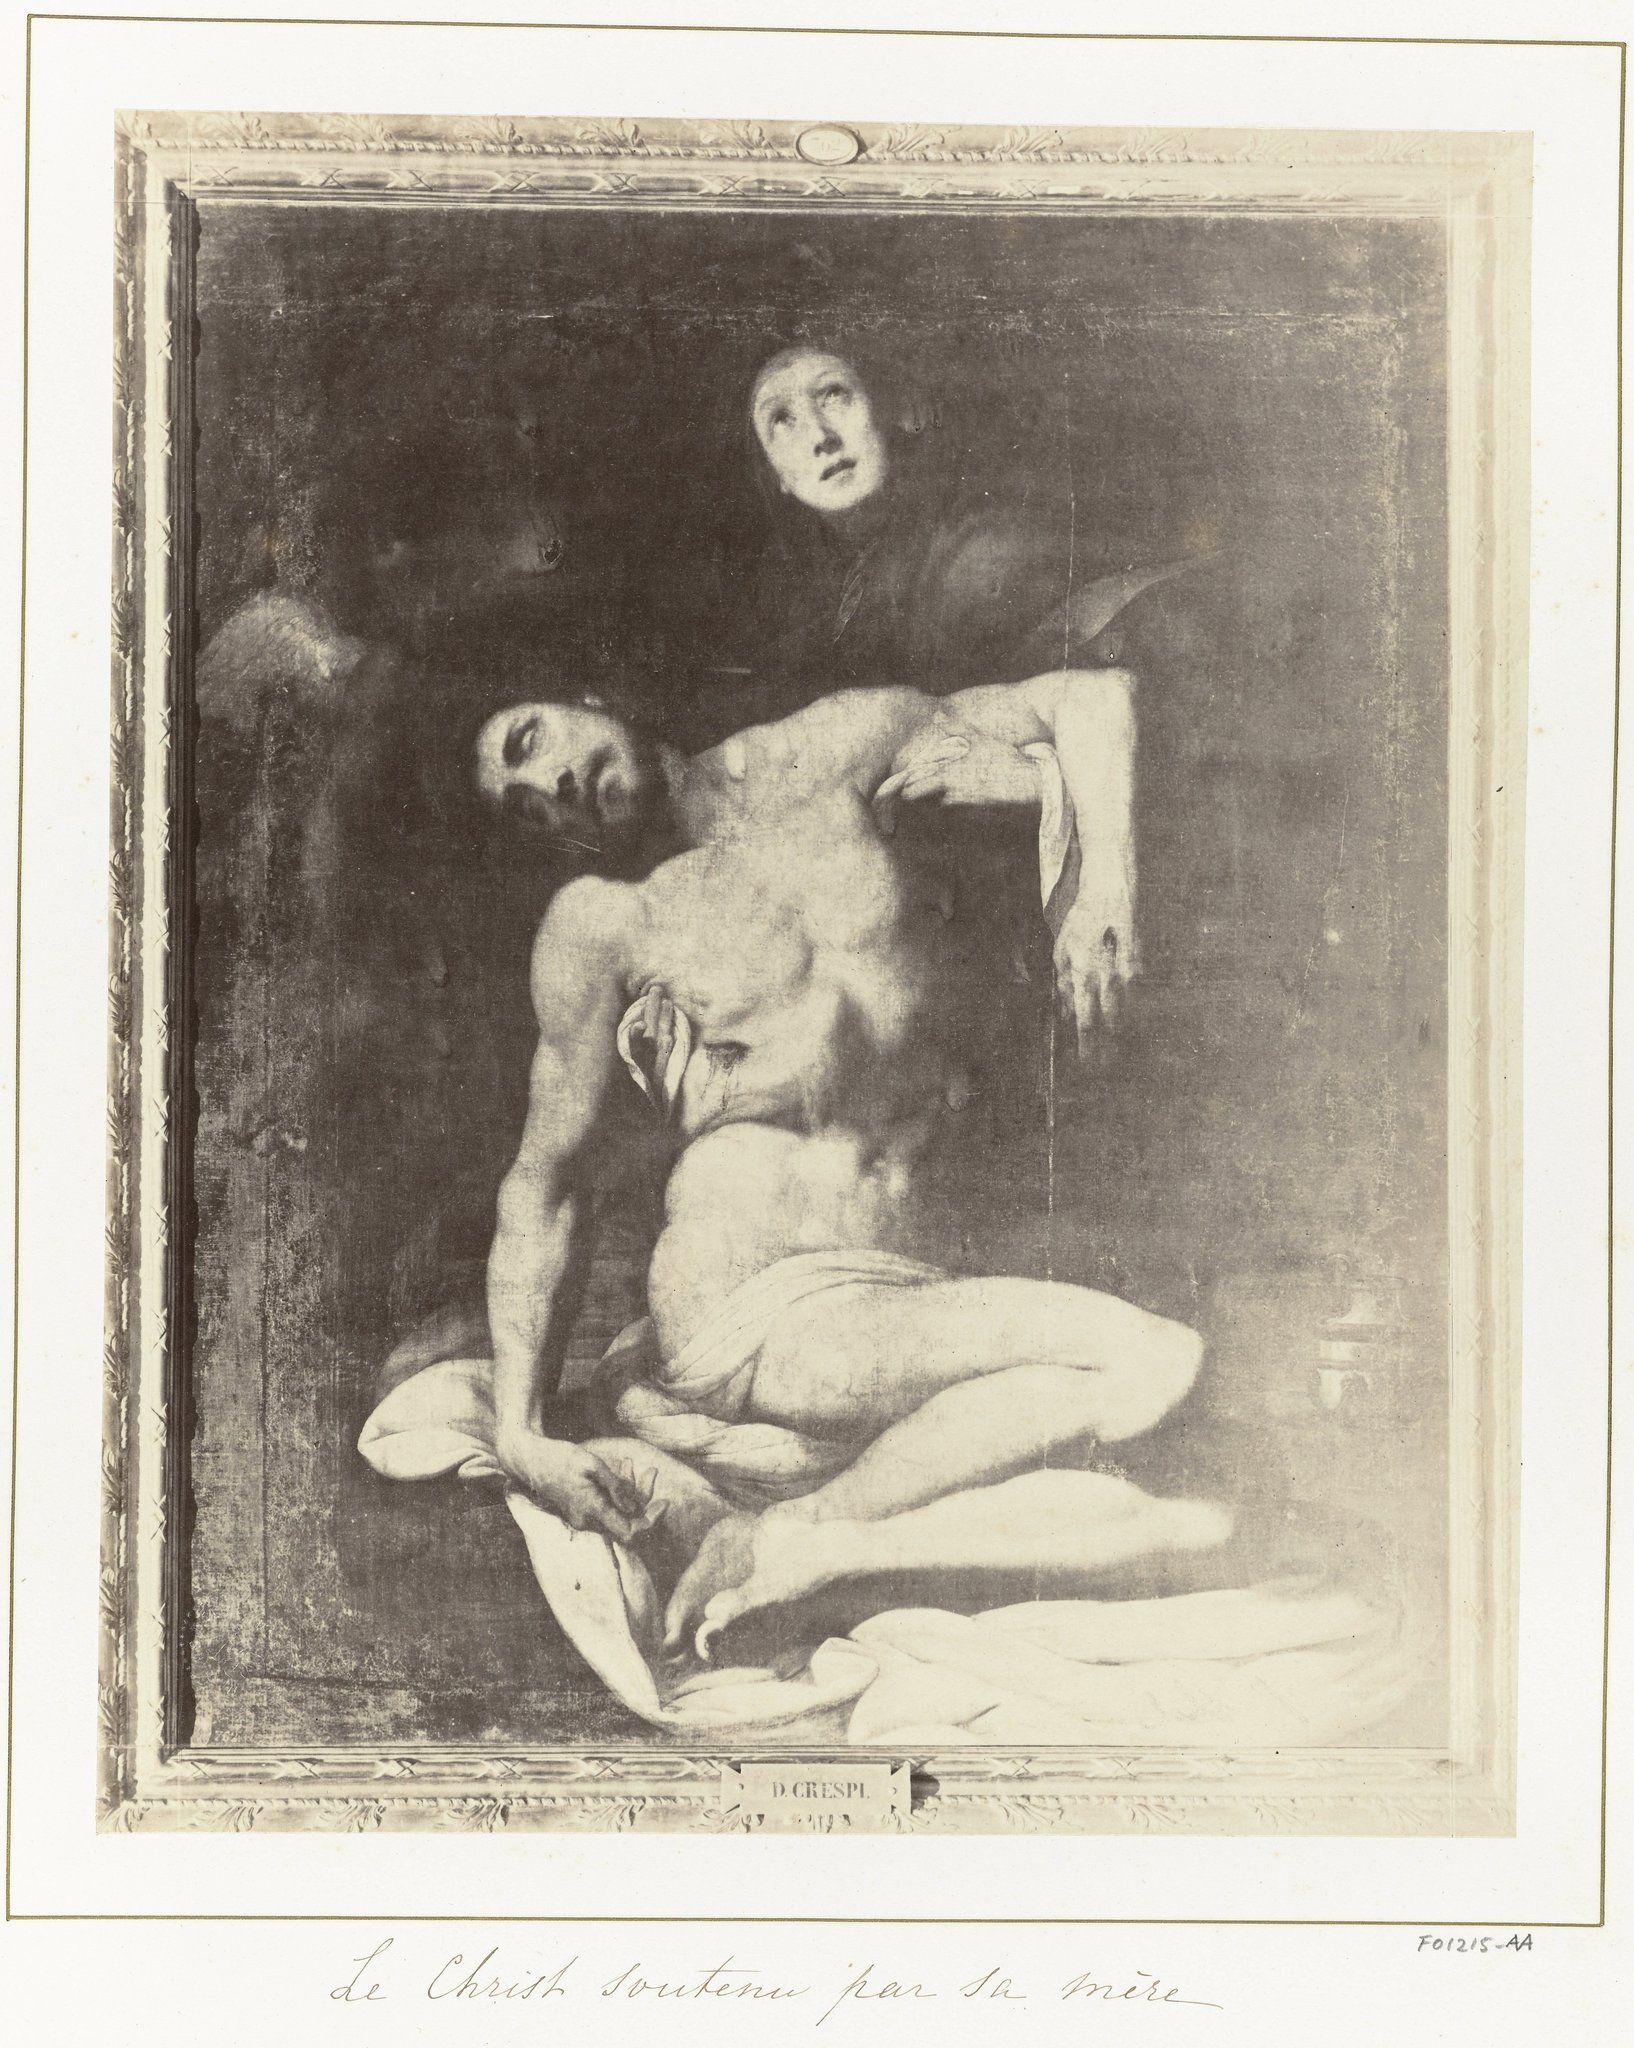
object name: photograph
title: Fotoreproductie van een schilderij, voorstellend een piëta door Daniele Crespi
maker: Anonymous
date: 1860-1875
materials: photographic support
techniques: albumen print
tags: the dead christ lying at mary's feet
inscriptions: inscription: ‘cuadros del Rl. Museo M[...]’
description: Onderdeel van Reisalbum met opnames van kunstwerken, personen en bezienswaardigheden in Spanje.